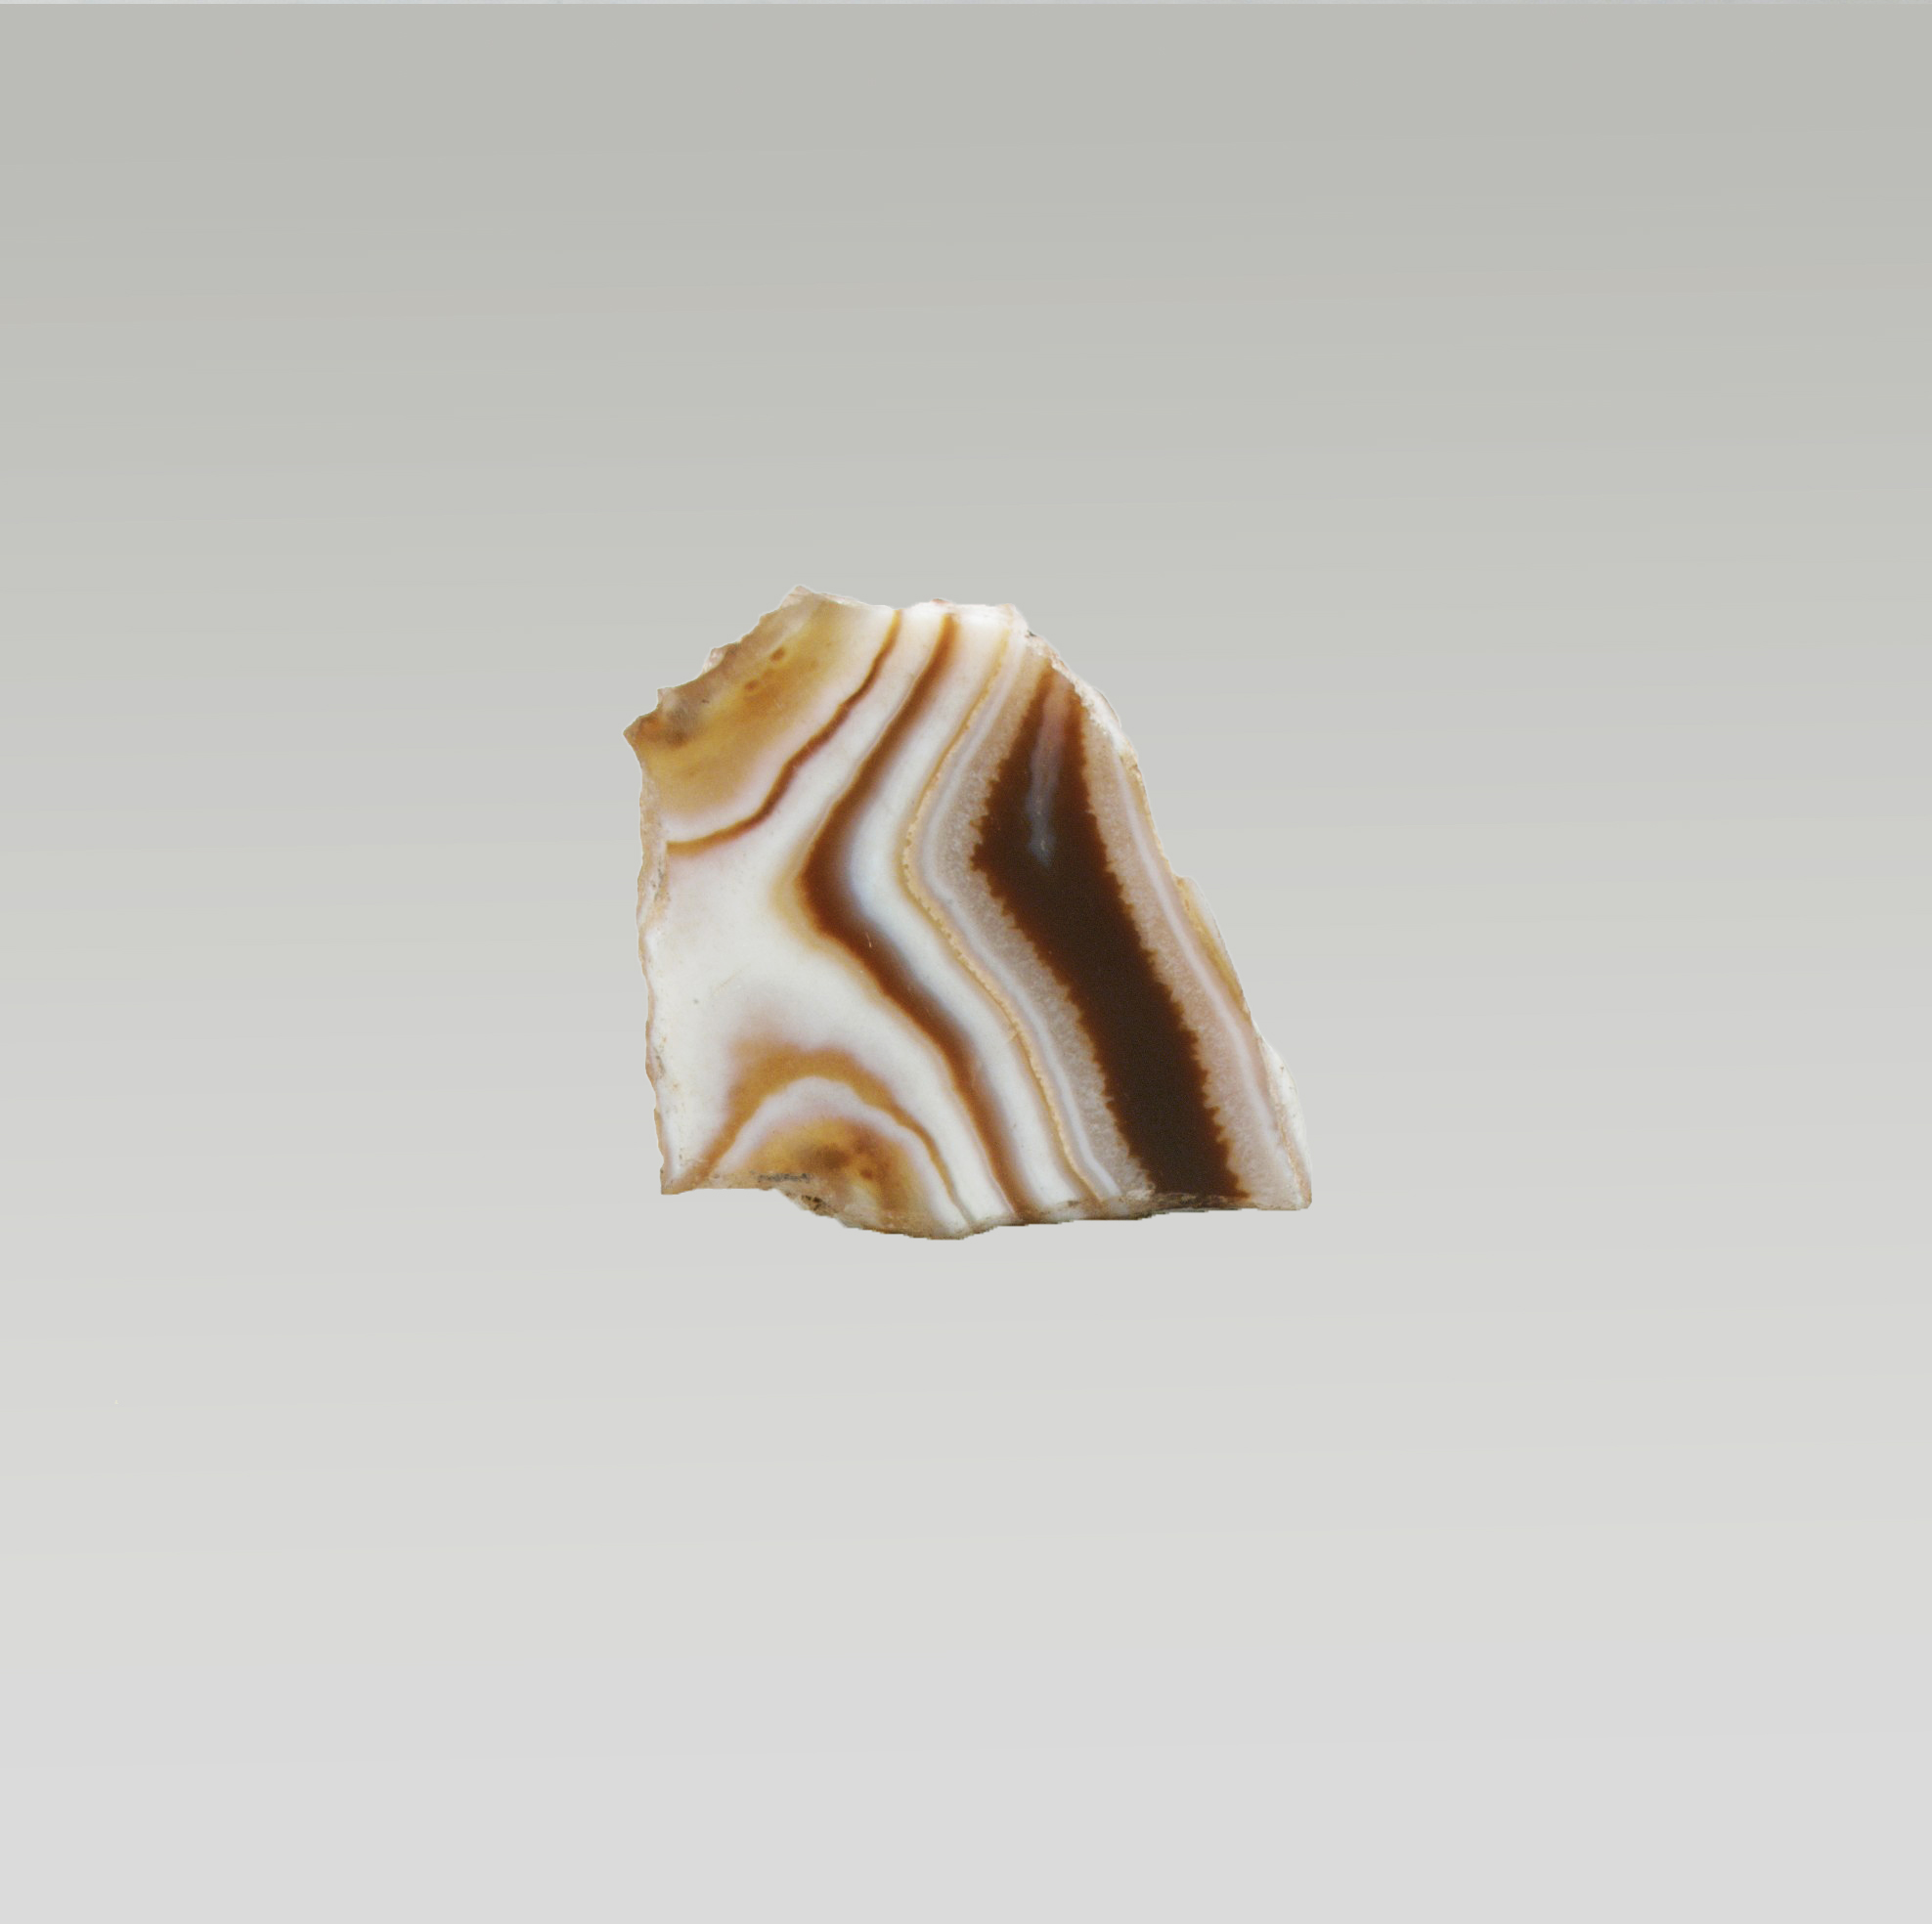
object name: fragment, inlay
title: Banded agate inlay fragment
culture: roman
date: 34 BCE-33 CE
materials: glass